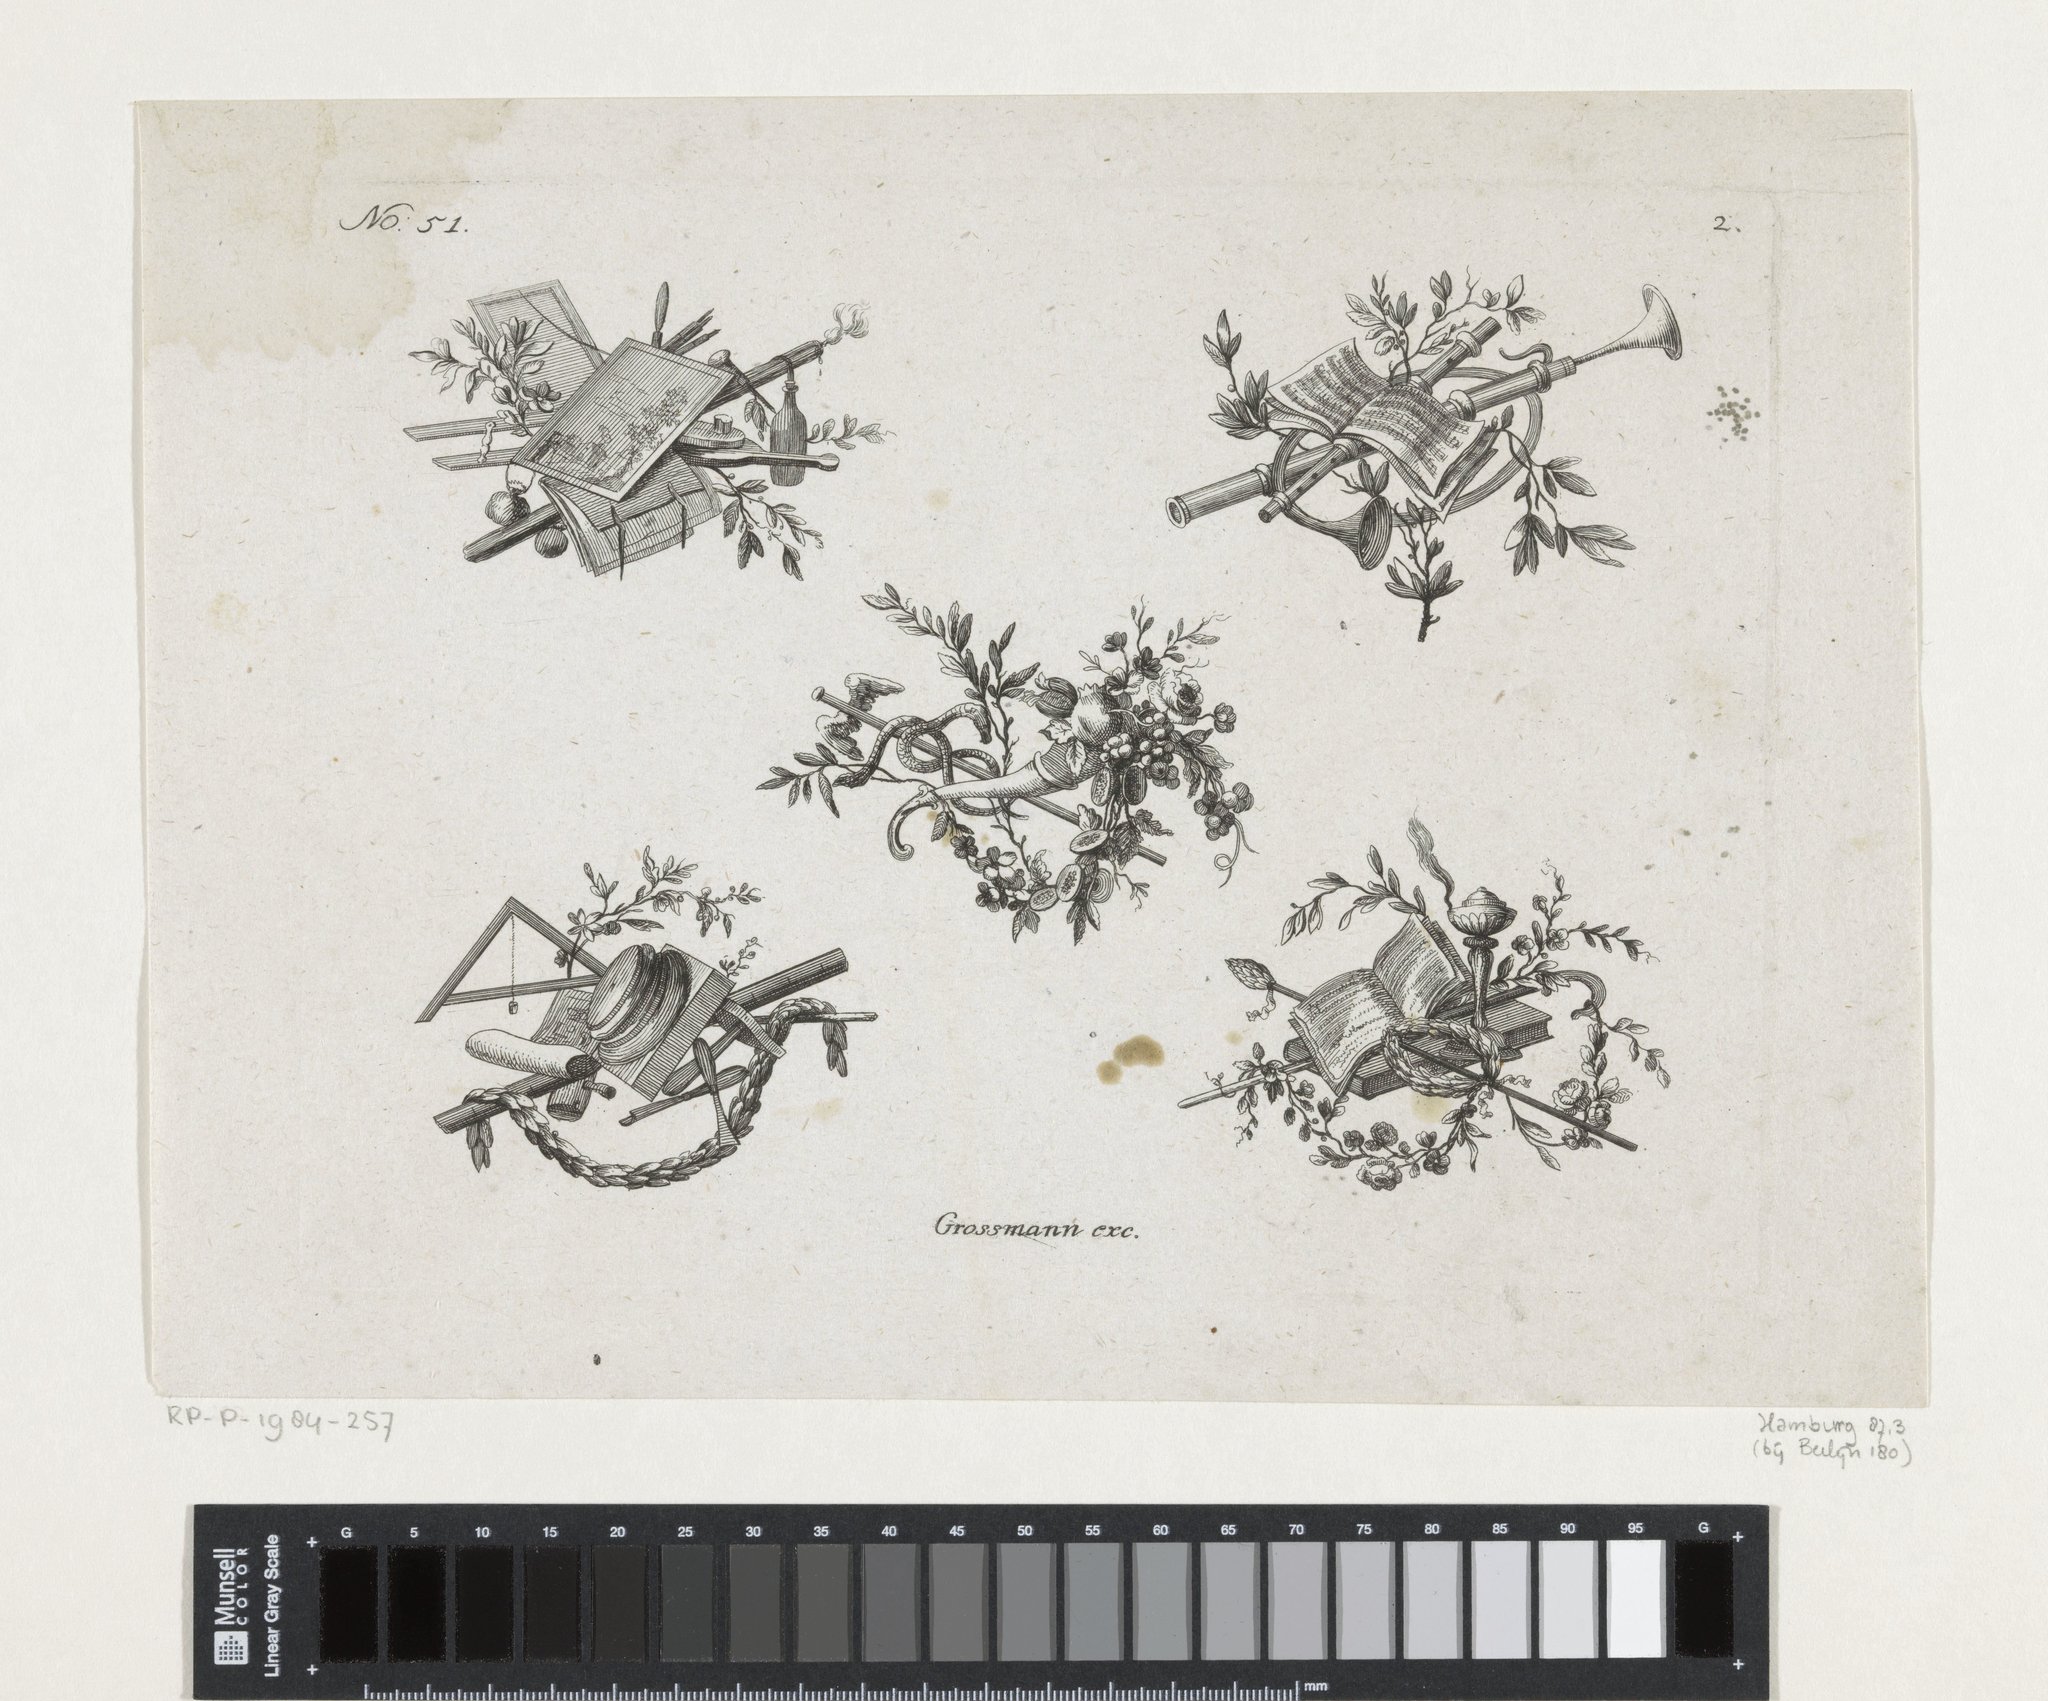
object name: ornament print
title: Trofeeën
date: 1751-1798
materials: paper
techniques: etching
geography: augsburg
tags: 'cornucopia', horn of plenty, symbolic representations, allegories and emblems ~ applied arts, symbolic representations, allegories and emblems ~ science, 'scientia'; 'scienza', 'studio' (ripa)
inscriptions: collector's mark: Lugt 2228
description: Vijf trofeeën met attributen van kunsten en wetenschappen. Links boven etskunst, rechts boven muziek, midden de hoorn des overvloeds met mercuriusstaf en slang, links onder graveerkunst, rechts onder een boek met lauwerkrans. Uitgeversnummer 51.